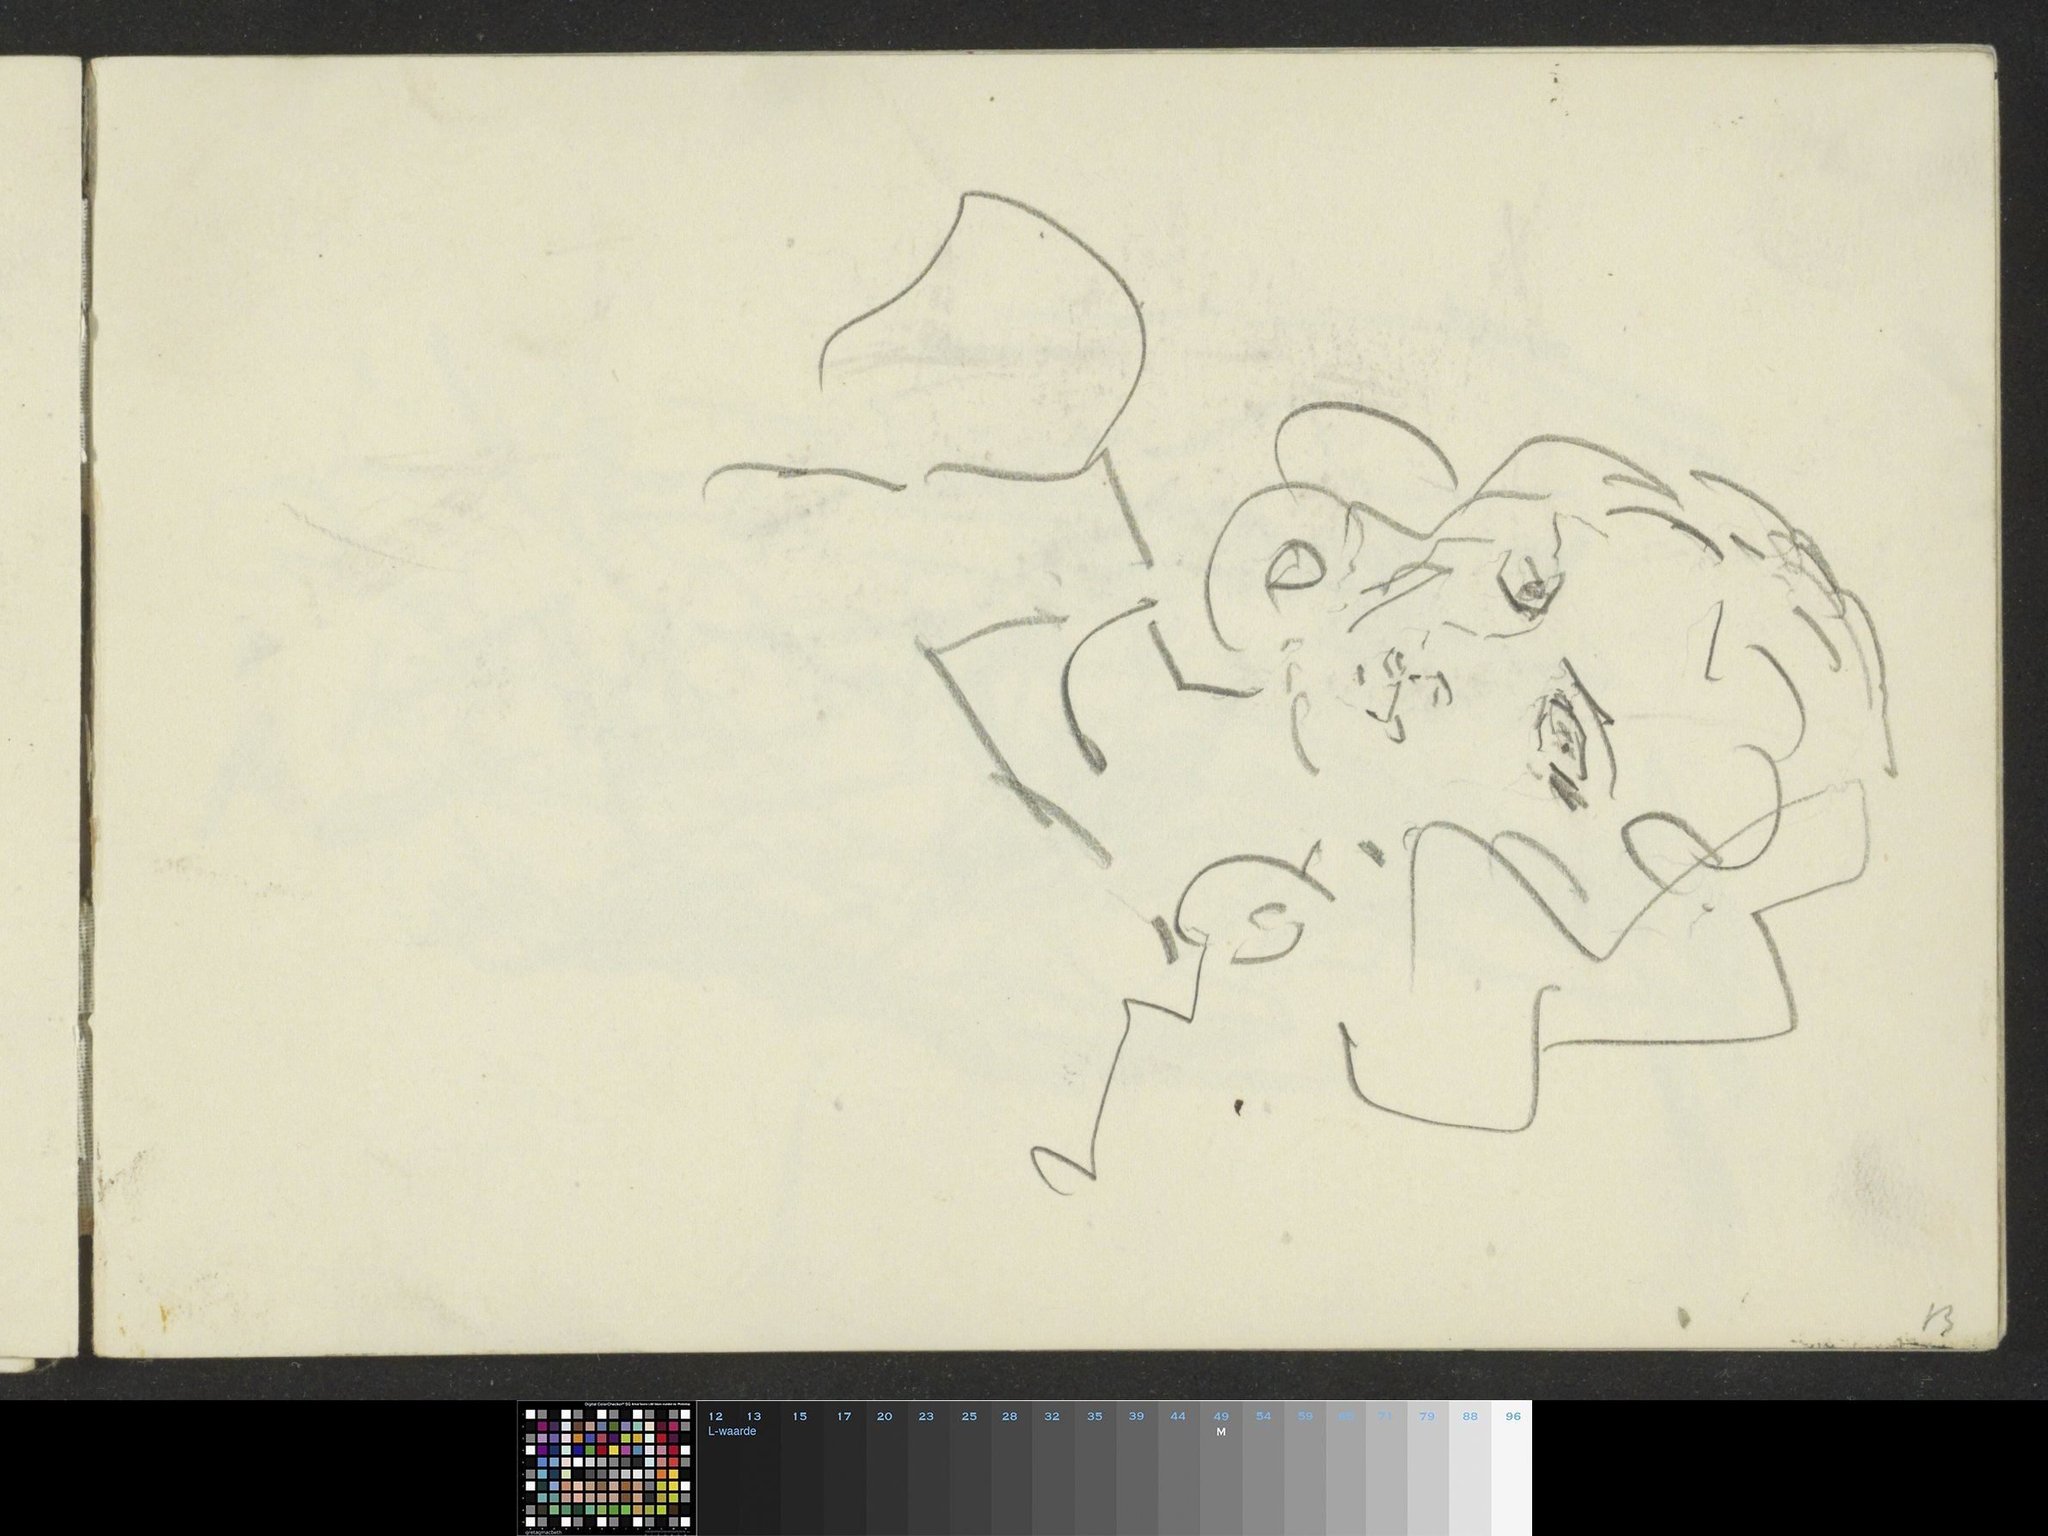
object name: sketchbook leaf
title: Vrouwenhoofd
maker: isaac israels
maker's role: draughtsman, painter, print maker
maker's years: 1865-1934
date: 1875-1934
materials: paper, pencil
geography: the hague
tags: head (human) - aa - female human figure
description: Blad 13 recto uit schetsboek LXI met 20 bladen.